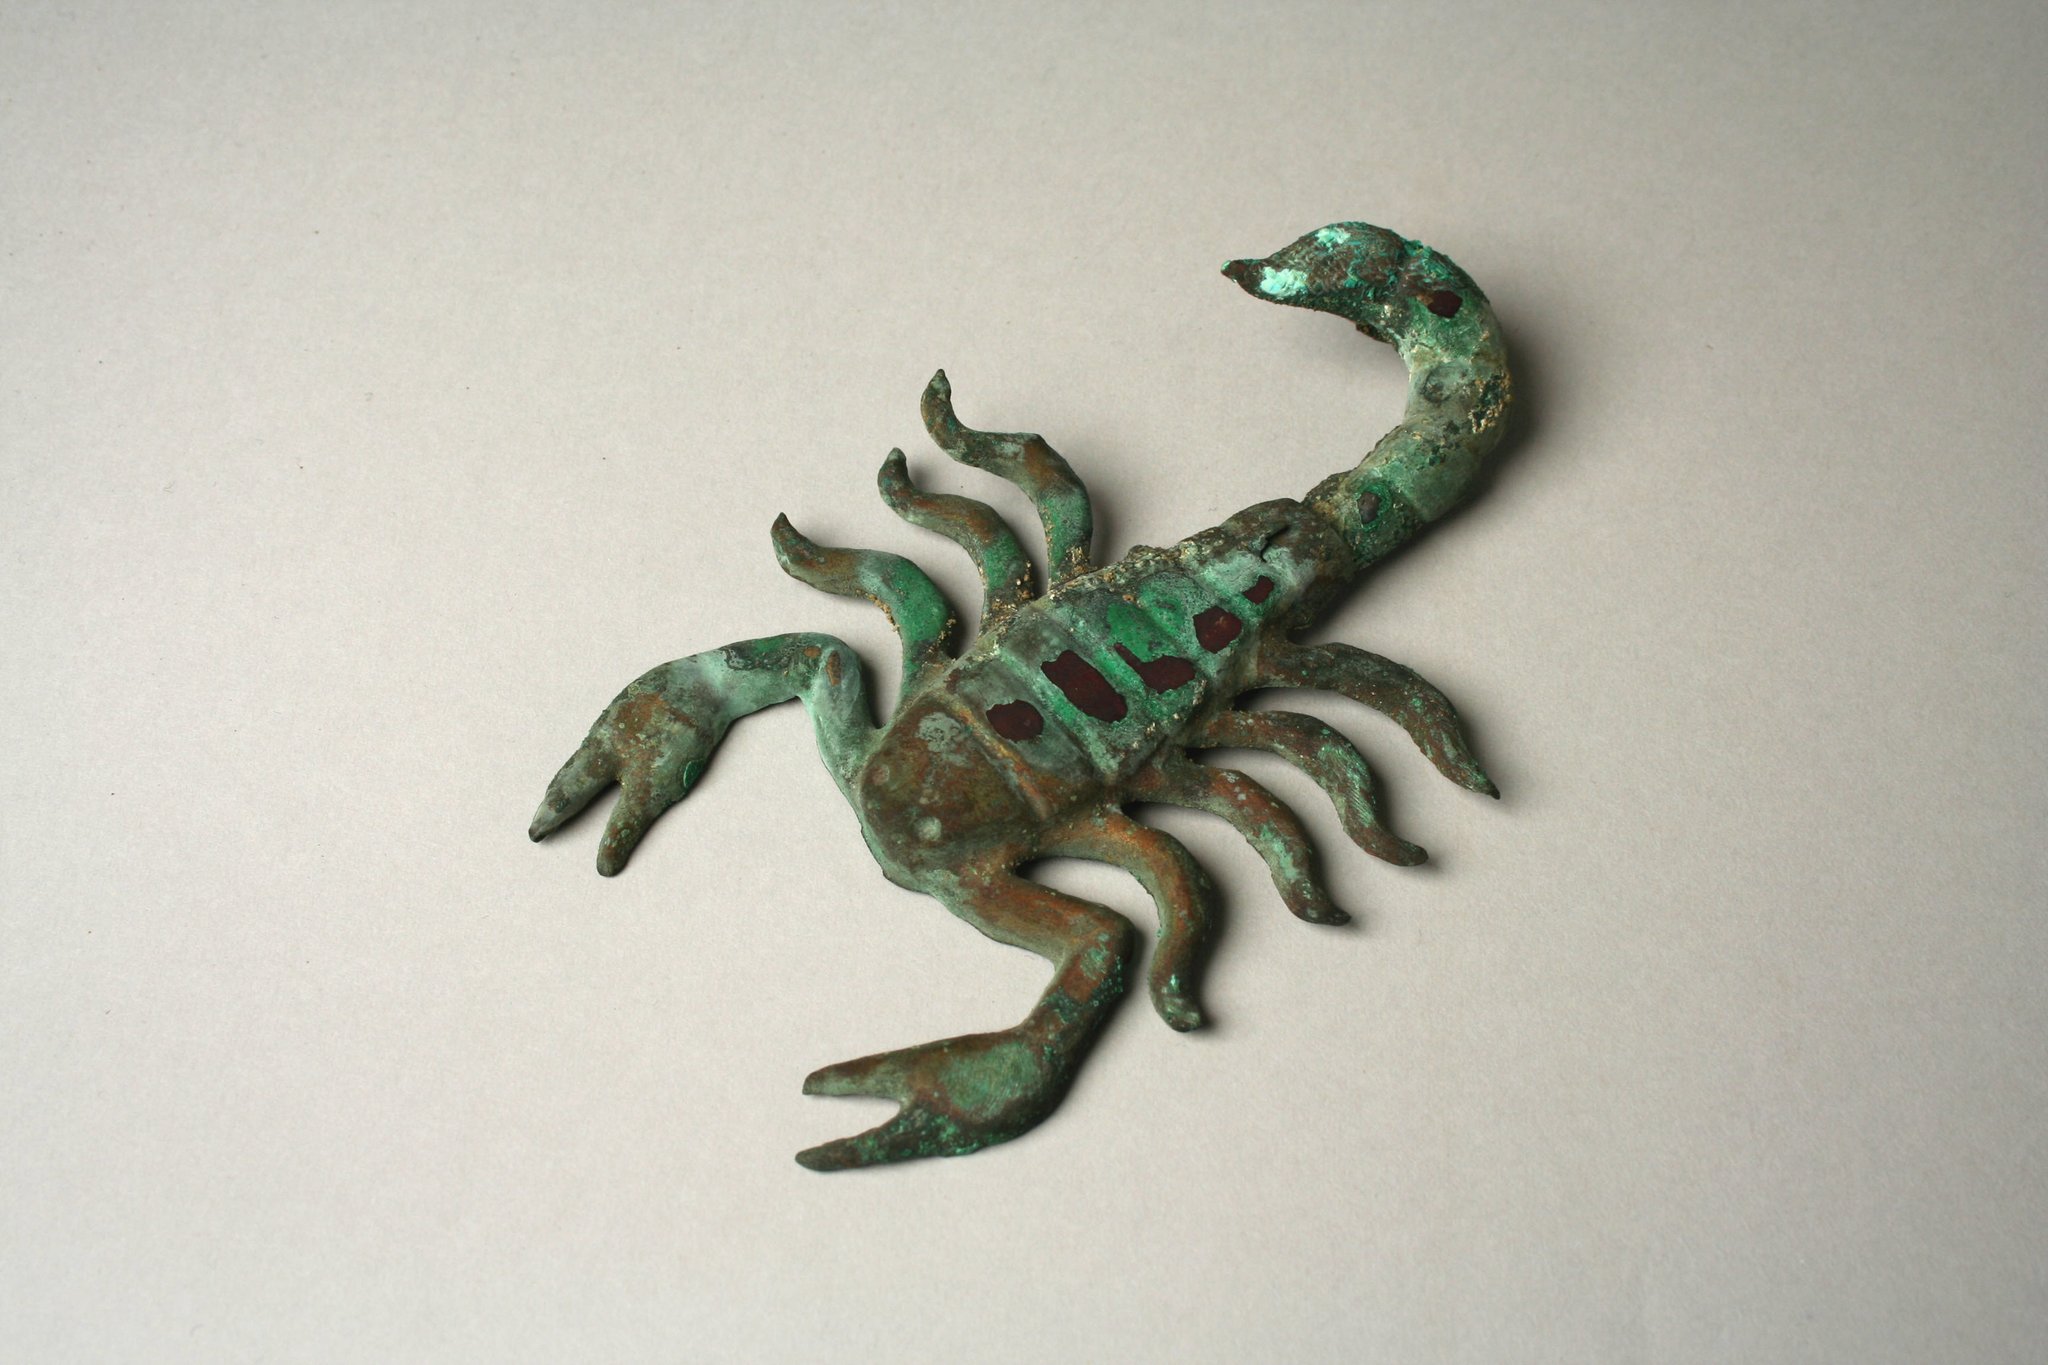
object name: ornament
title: Scorpion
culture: moche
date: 501-700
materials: gilt copper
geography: peru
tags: scorpions